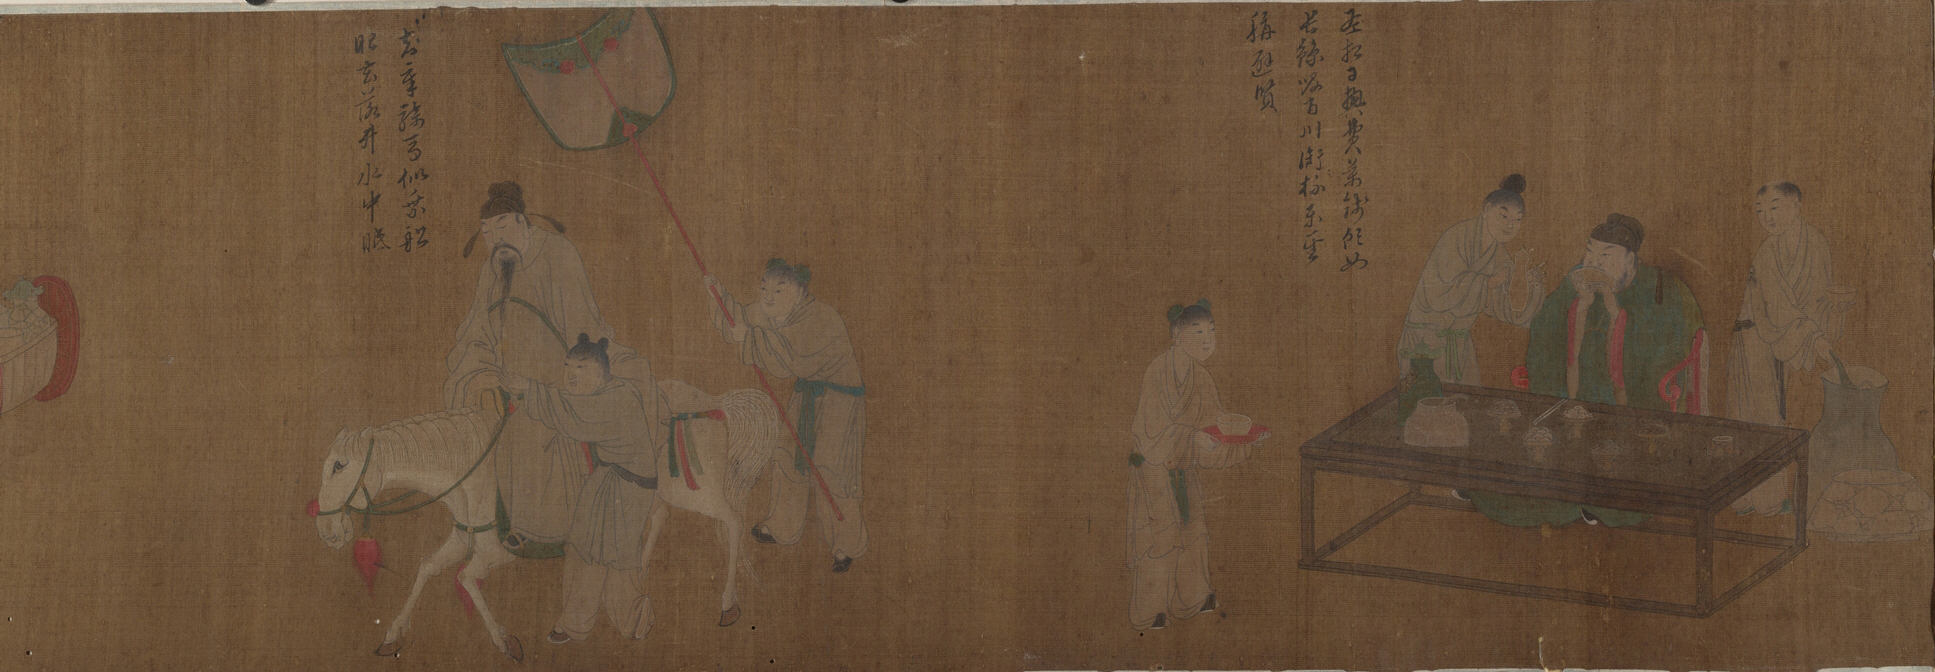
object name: handscroll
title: The Eight Drunkards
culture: chinese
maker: unidentified artist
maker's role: artist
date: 1368-1911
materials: ink, silk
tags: men,horses,drinking